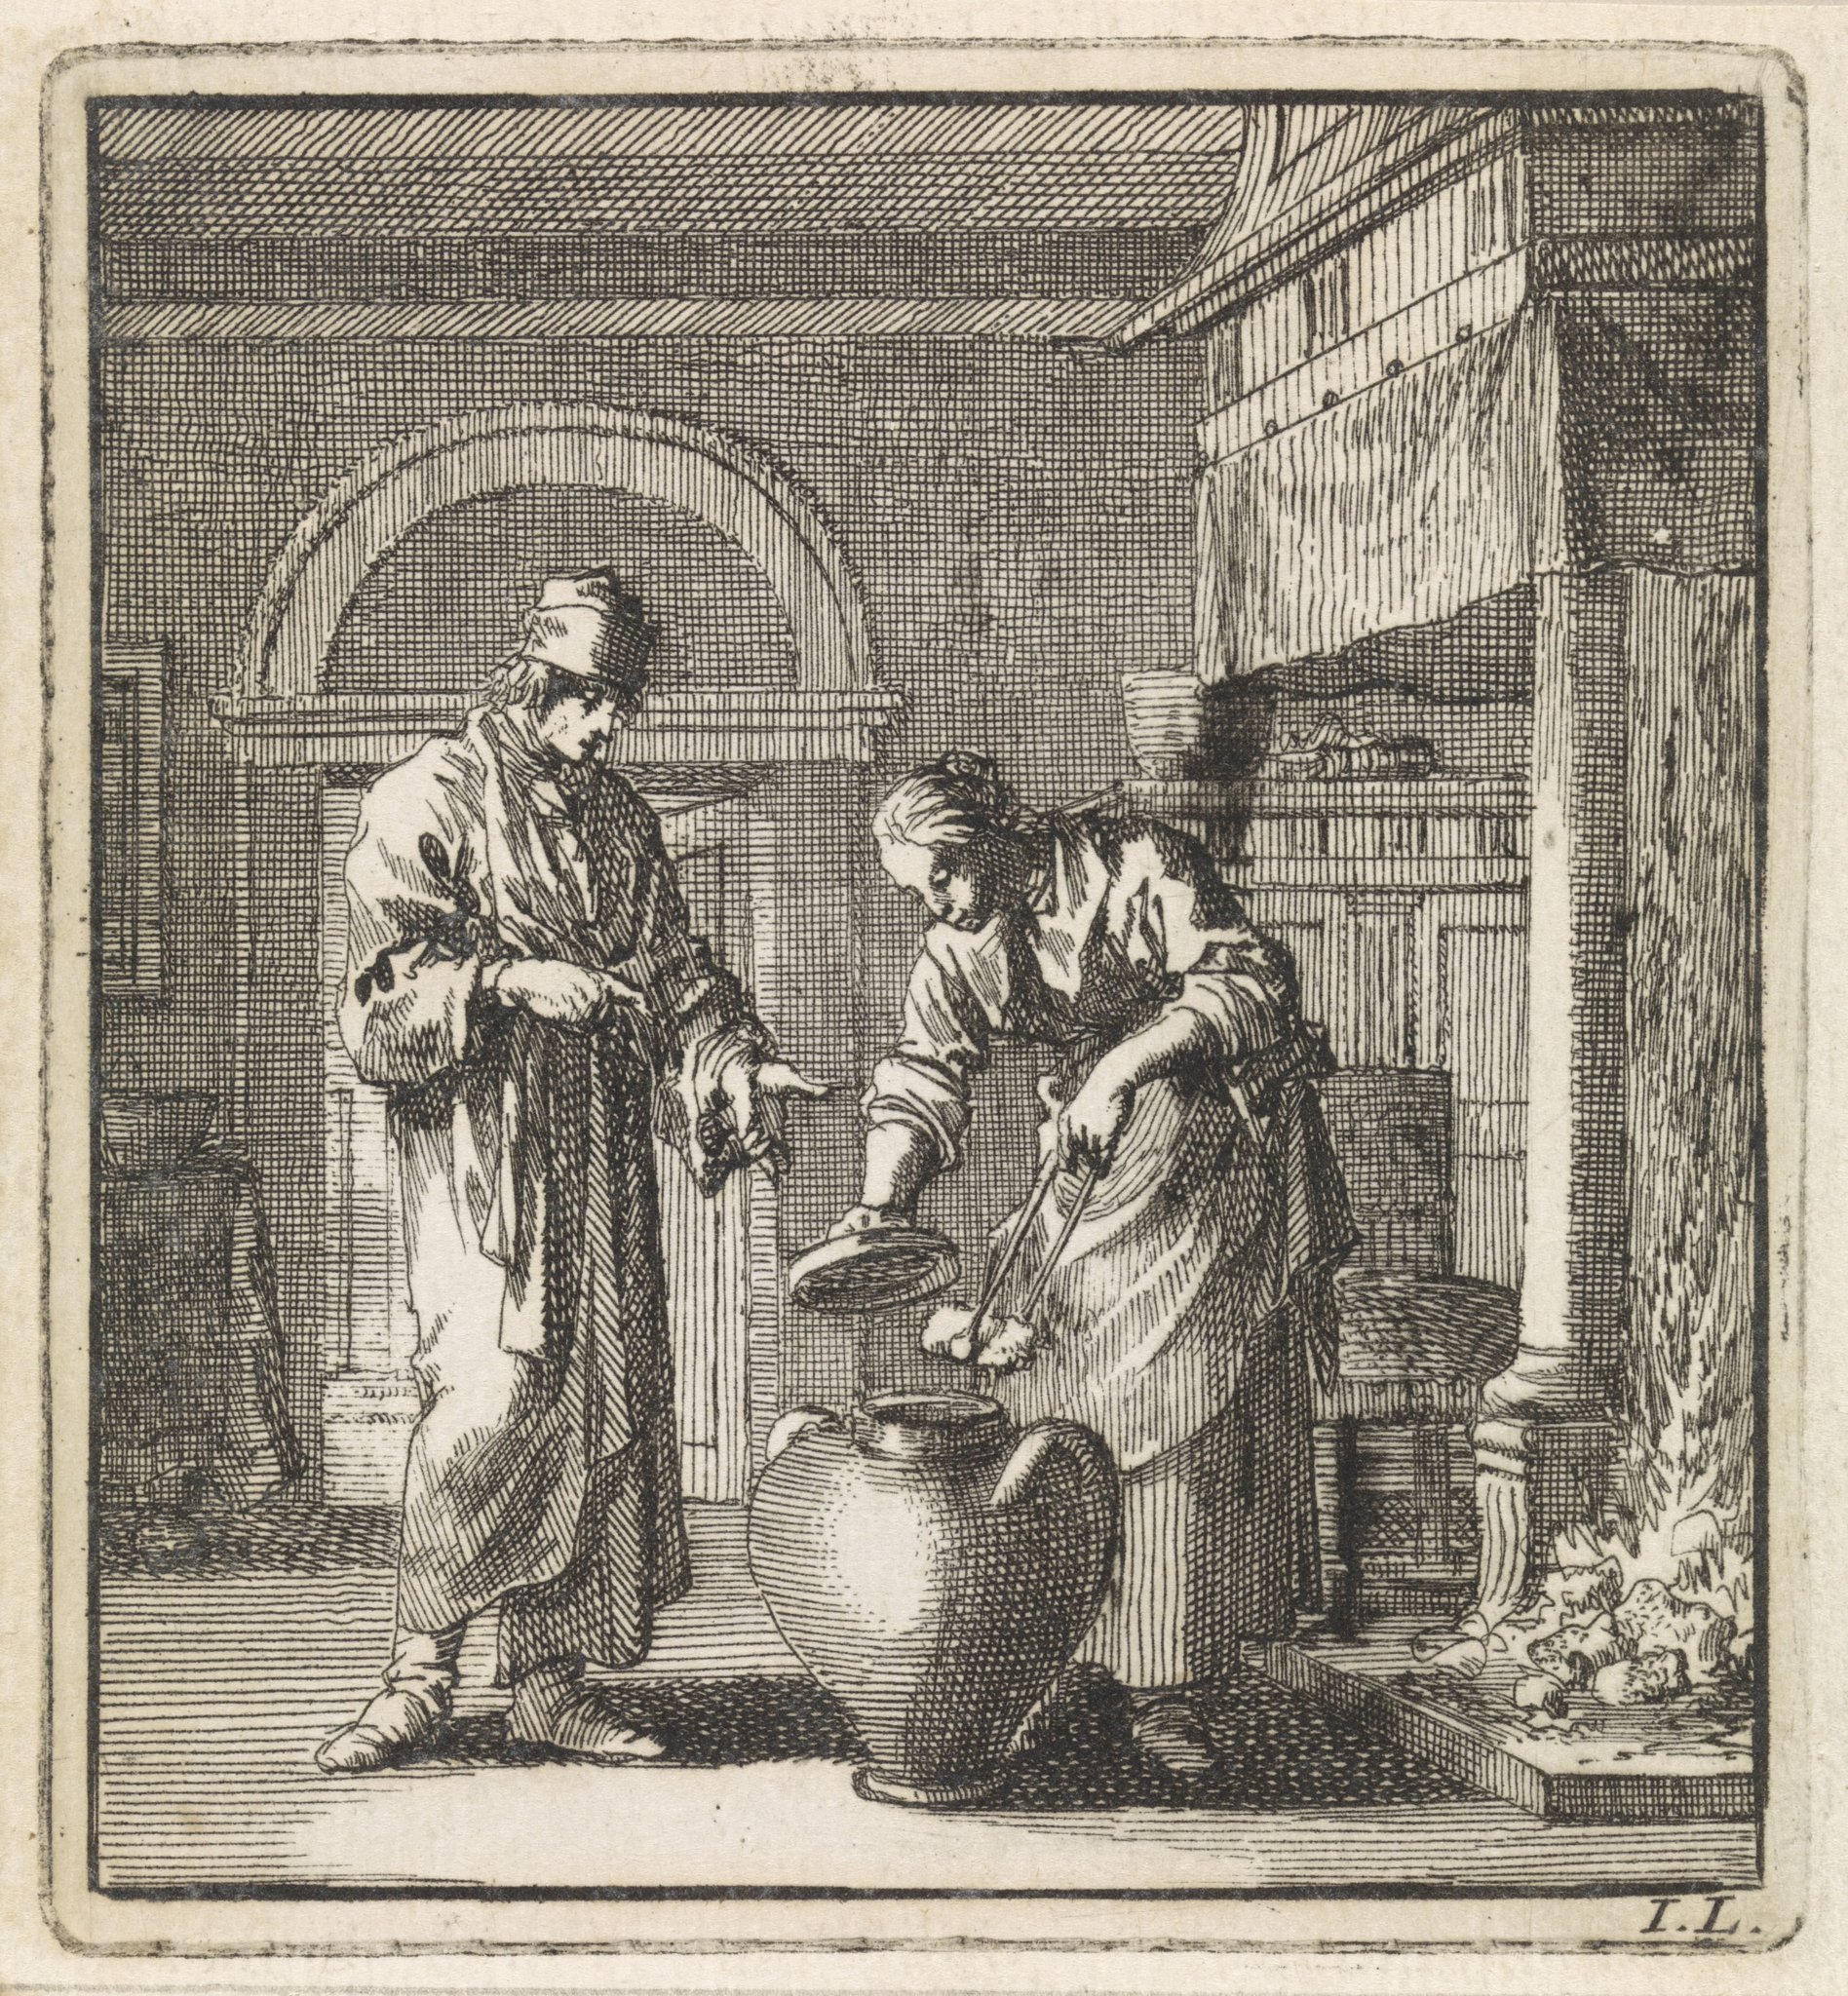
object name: book illustration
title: Vrouw stopt een gloeiende kool in de doofpot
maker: jan luyken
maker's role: draughtsman, print maker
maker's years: 1649-1712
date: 1711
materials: paper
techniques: etching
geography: amsterdam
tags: chimney, container of ceramics: jar, jug, pot, vase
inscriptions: collector's mark: Lugt 2228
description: Proefdruk van illustratie voor: Luyken, Jan. Het leerzaam huisraad, vertoond in vyftig konstige figuuren, met godlyke spreuken en stichtelyke verzen: Pieter Arentsz. II (wed.) en Cornelis van der Sys, 1711, p. 18.